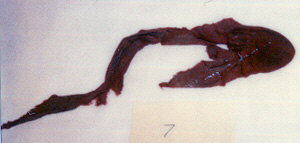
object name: textile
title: Textile fragment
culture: sasanian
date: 501-700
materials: silk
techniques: weave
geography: iran